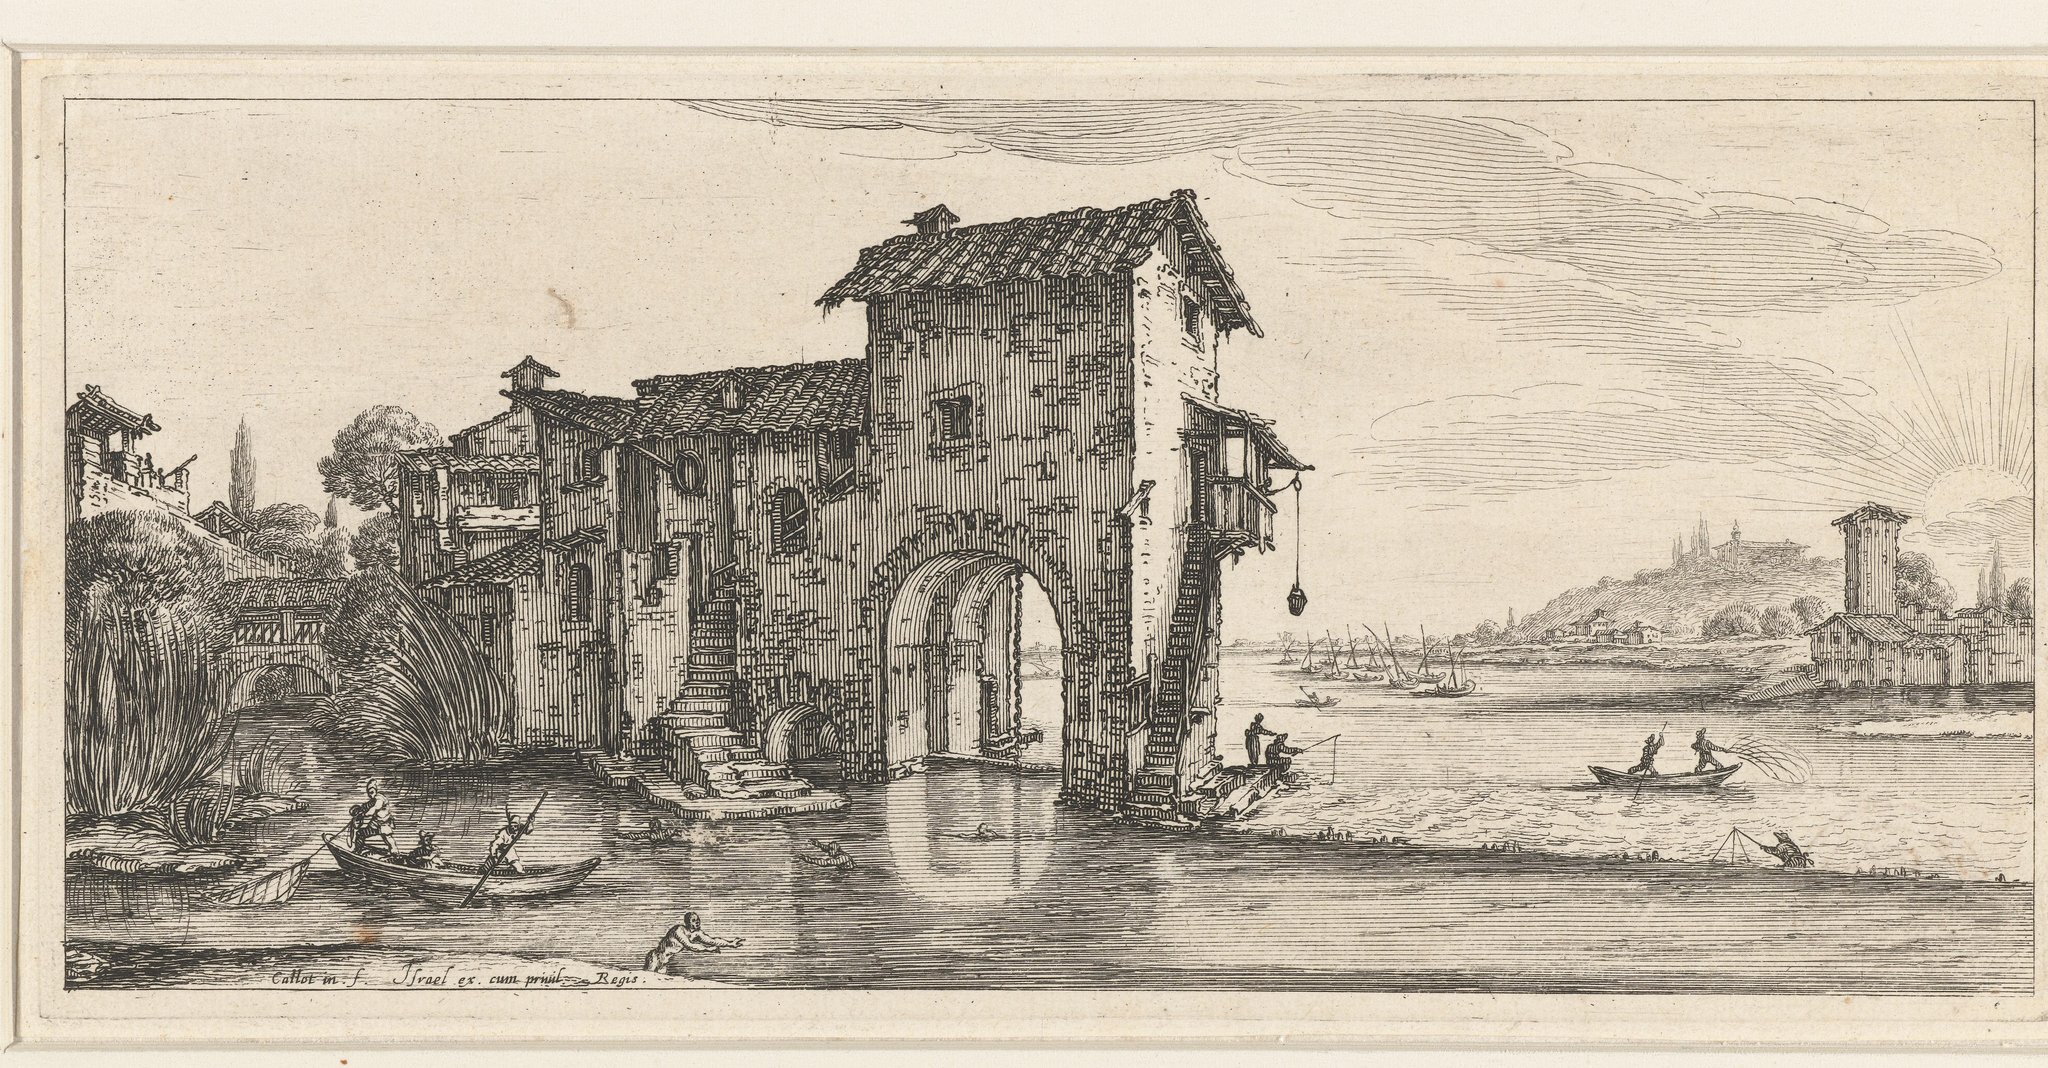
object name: print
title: Watermolen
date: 1628-1635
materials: paper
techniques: etching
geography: paris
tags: fishing (sports), swimming (sport), watermill in landscape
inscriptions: collector's mark: Lugt 240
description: Een watermolen aan een rivier of baai. In en op het water enkele zwemmers en vissers. Op de achtergrond rechts een heuvelachtig landschap met enkele huizen. Deze prent is onderdeel van een serie van 11 Italiaanse (waarschijnlijk voornamelijk Florentijnse) landschappen (12 incl. titelprent).